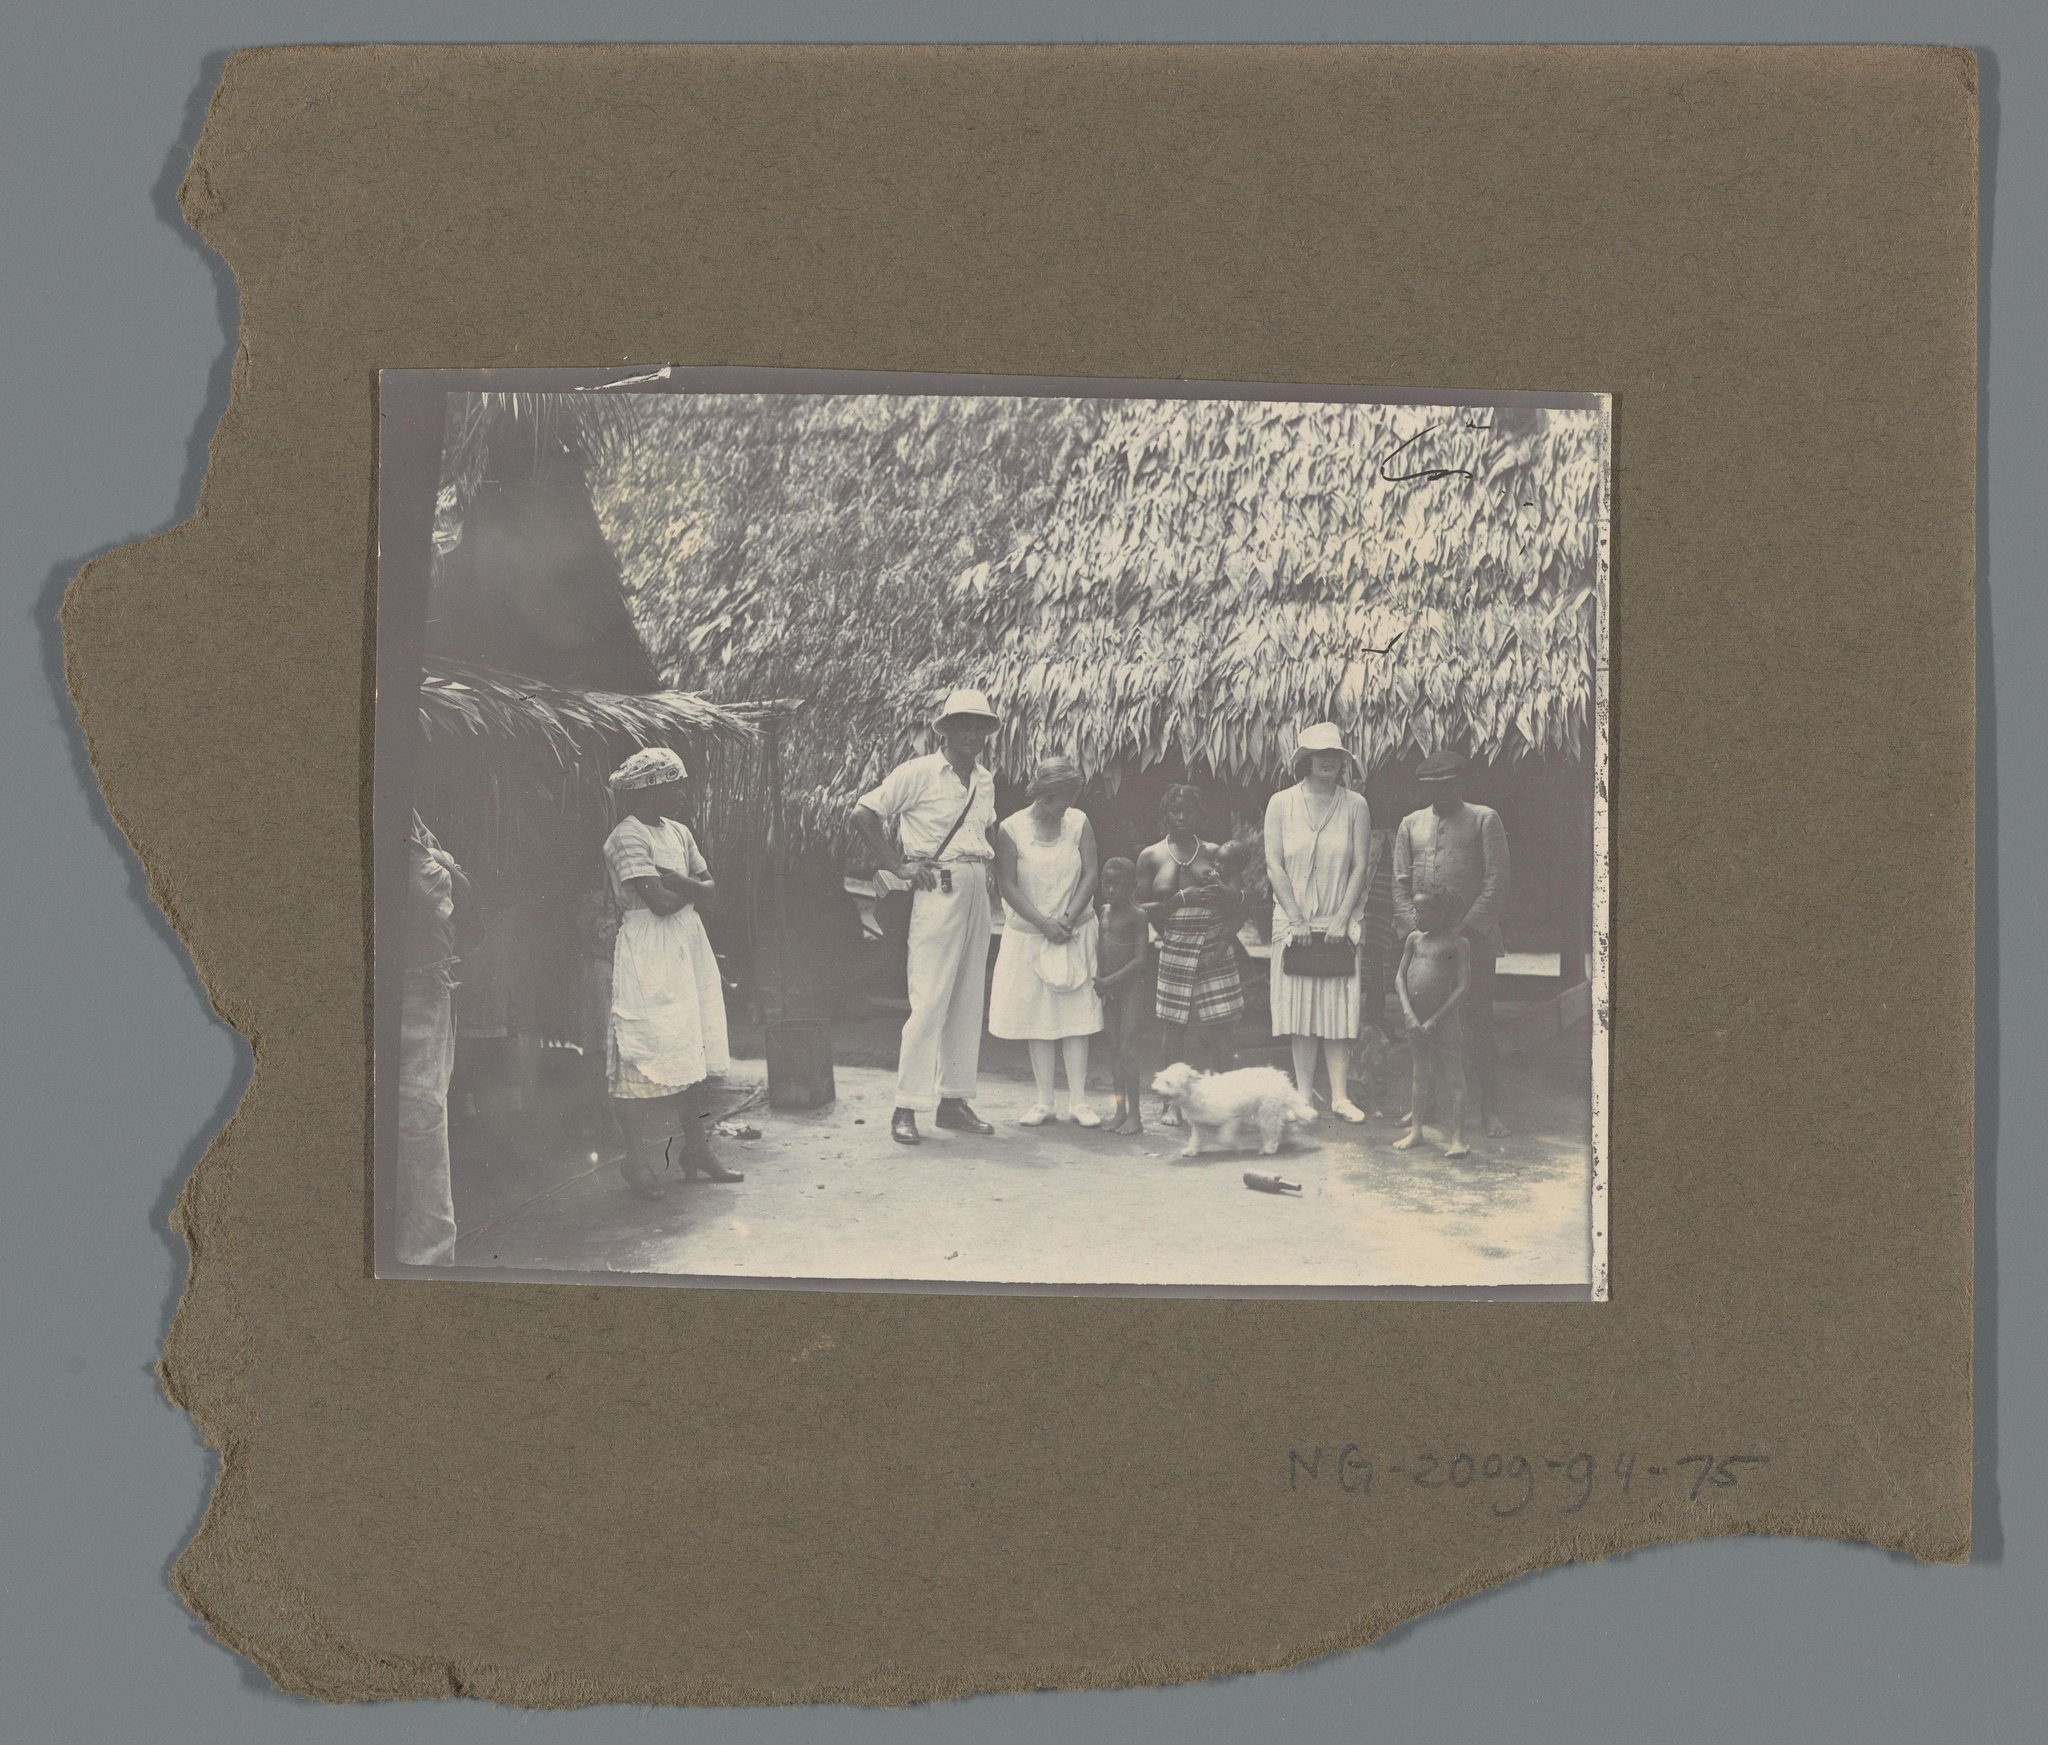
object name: photograph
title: Echtpaar Jetten in een inlands dorp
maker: Anonymous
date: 1925-1927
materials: photographic support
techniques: photography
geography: suriname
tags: jetten, familie, moengo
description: Groepsfoto met enkele dorpsbewoners, tijdens een bezoek van een groep Nederlanders, waaronder het echtpaar Jetten, aan een inlands dorp. Gescheurd uit blad 24/25 van het fotoalbum. Onderdeel van het ensemble met foto's van de familie van ingenieur Jetten in de mijnbouwstad Moengo in Suriname.